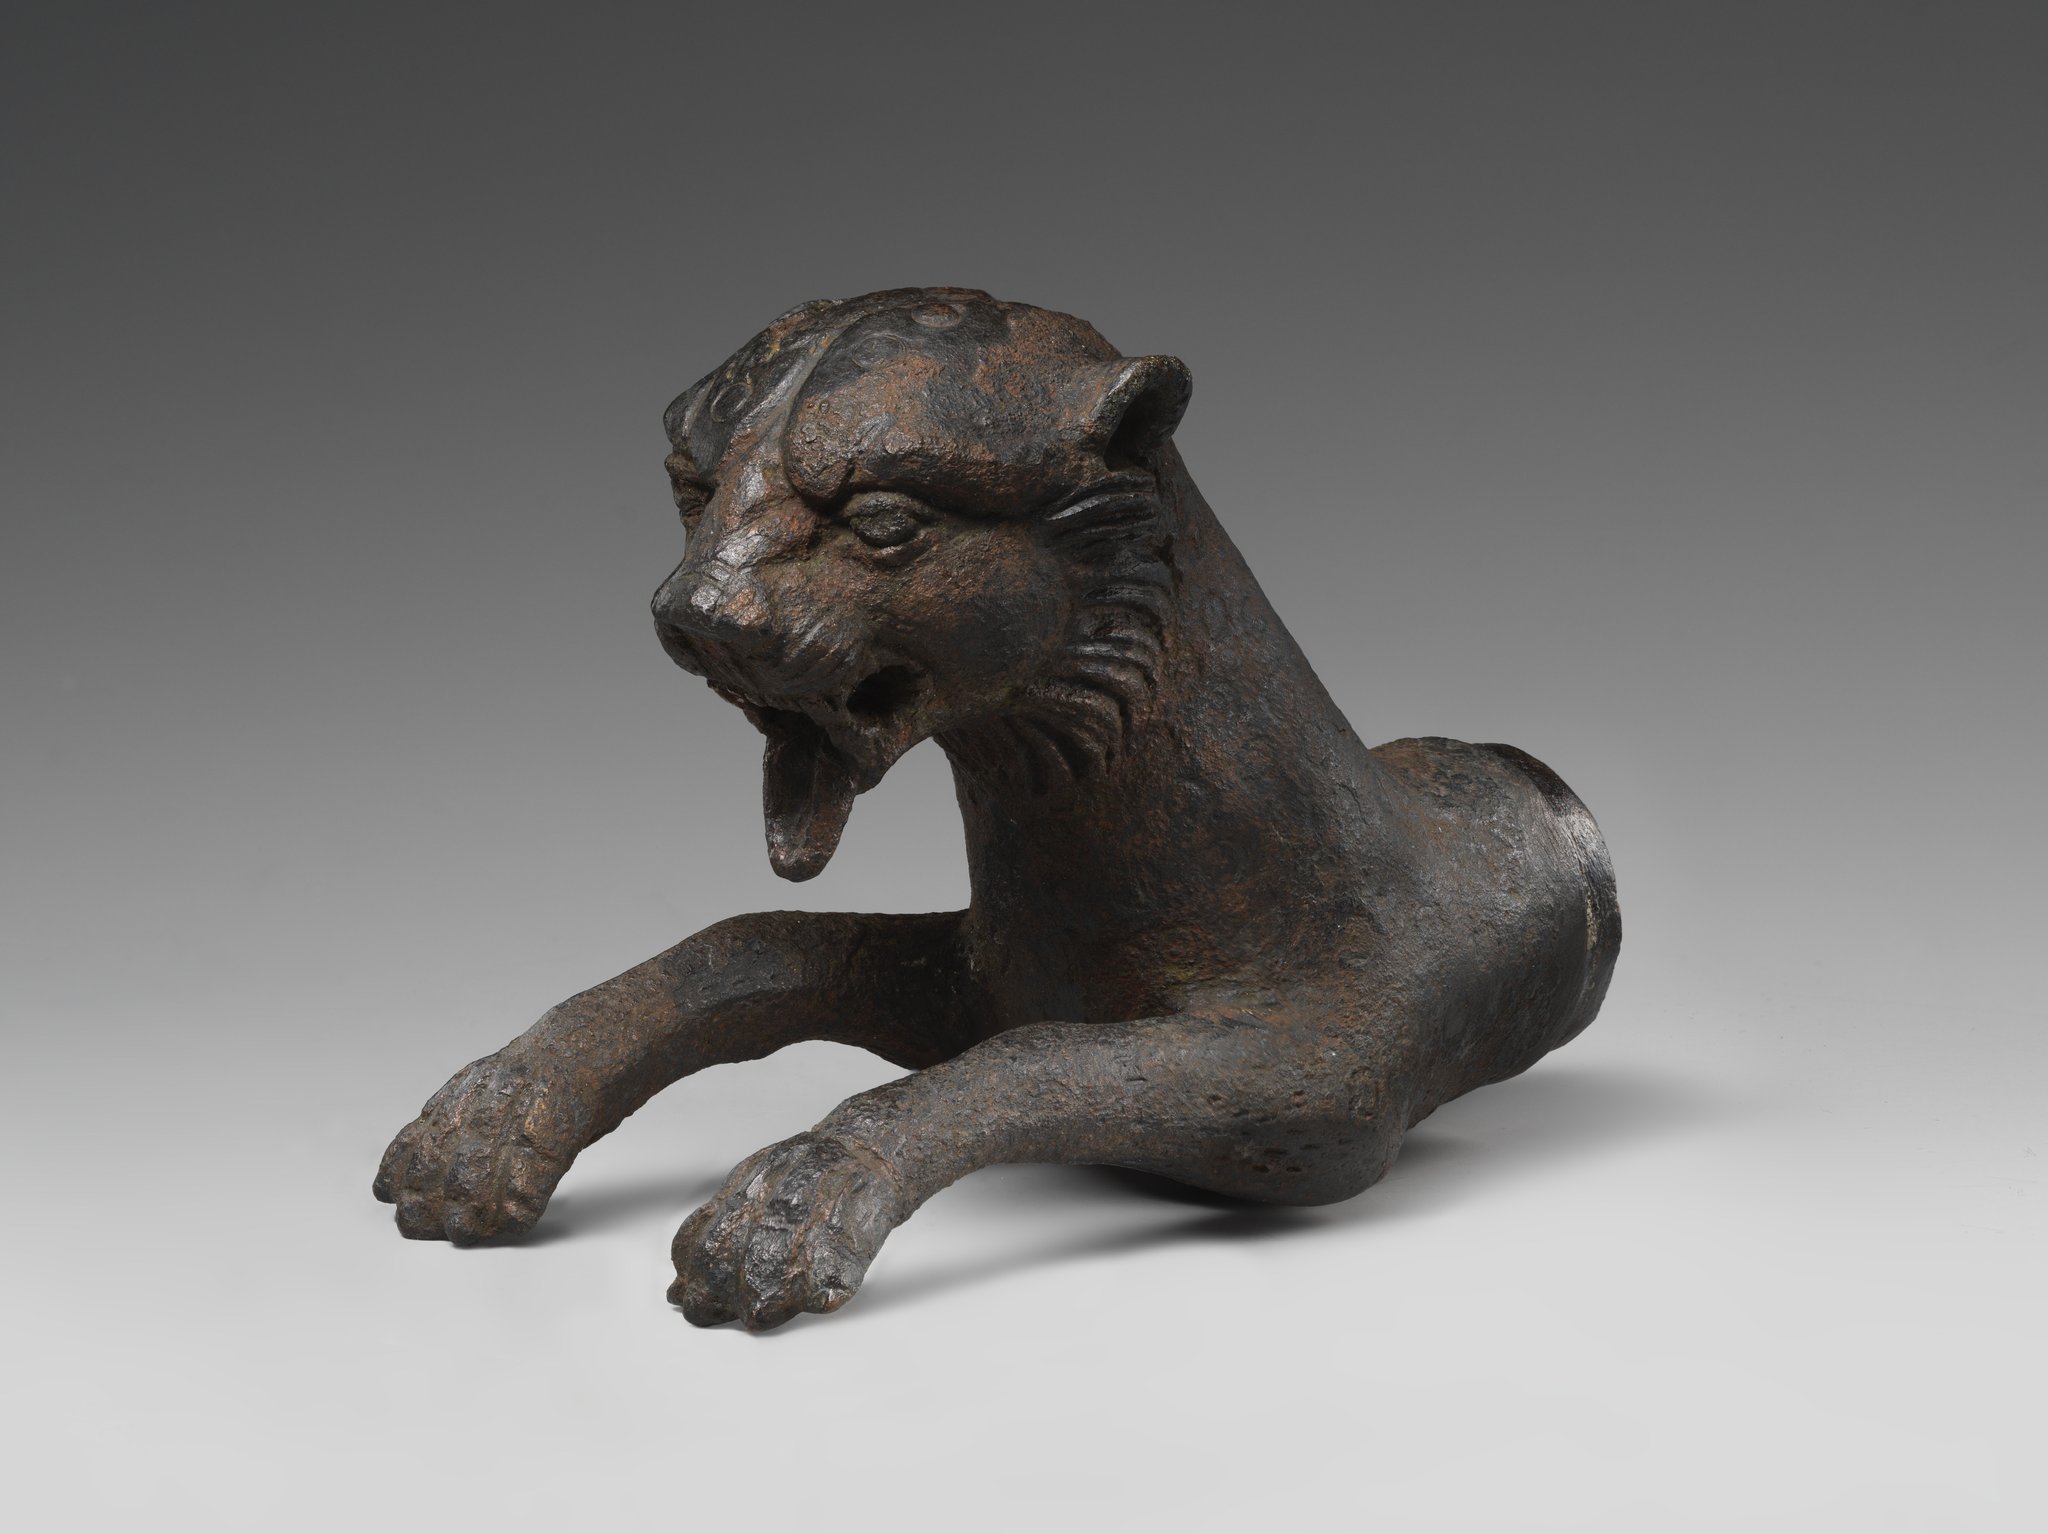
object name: sculpture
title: Forepart of a leopard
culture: parthian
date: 201-300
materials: bronze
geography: iran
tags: leopards